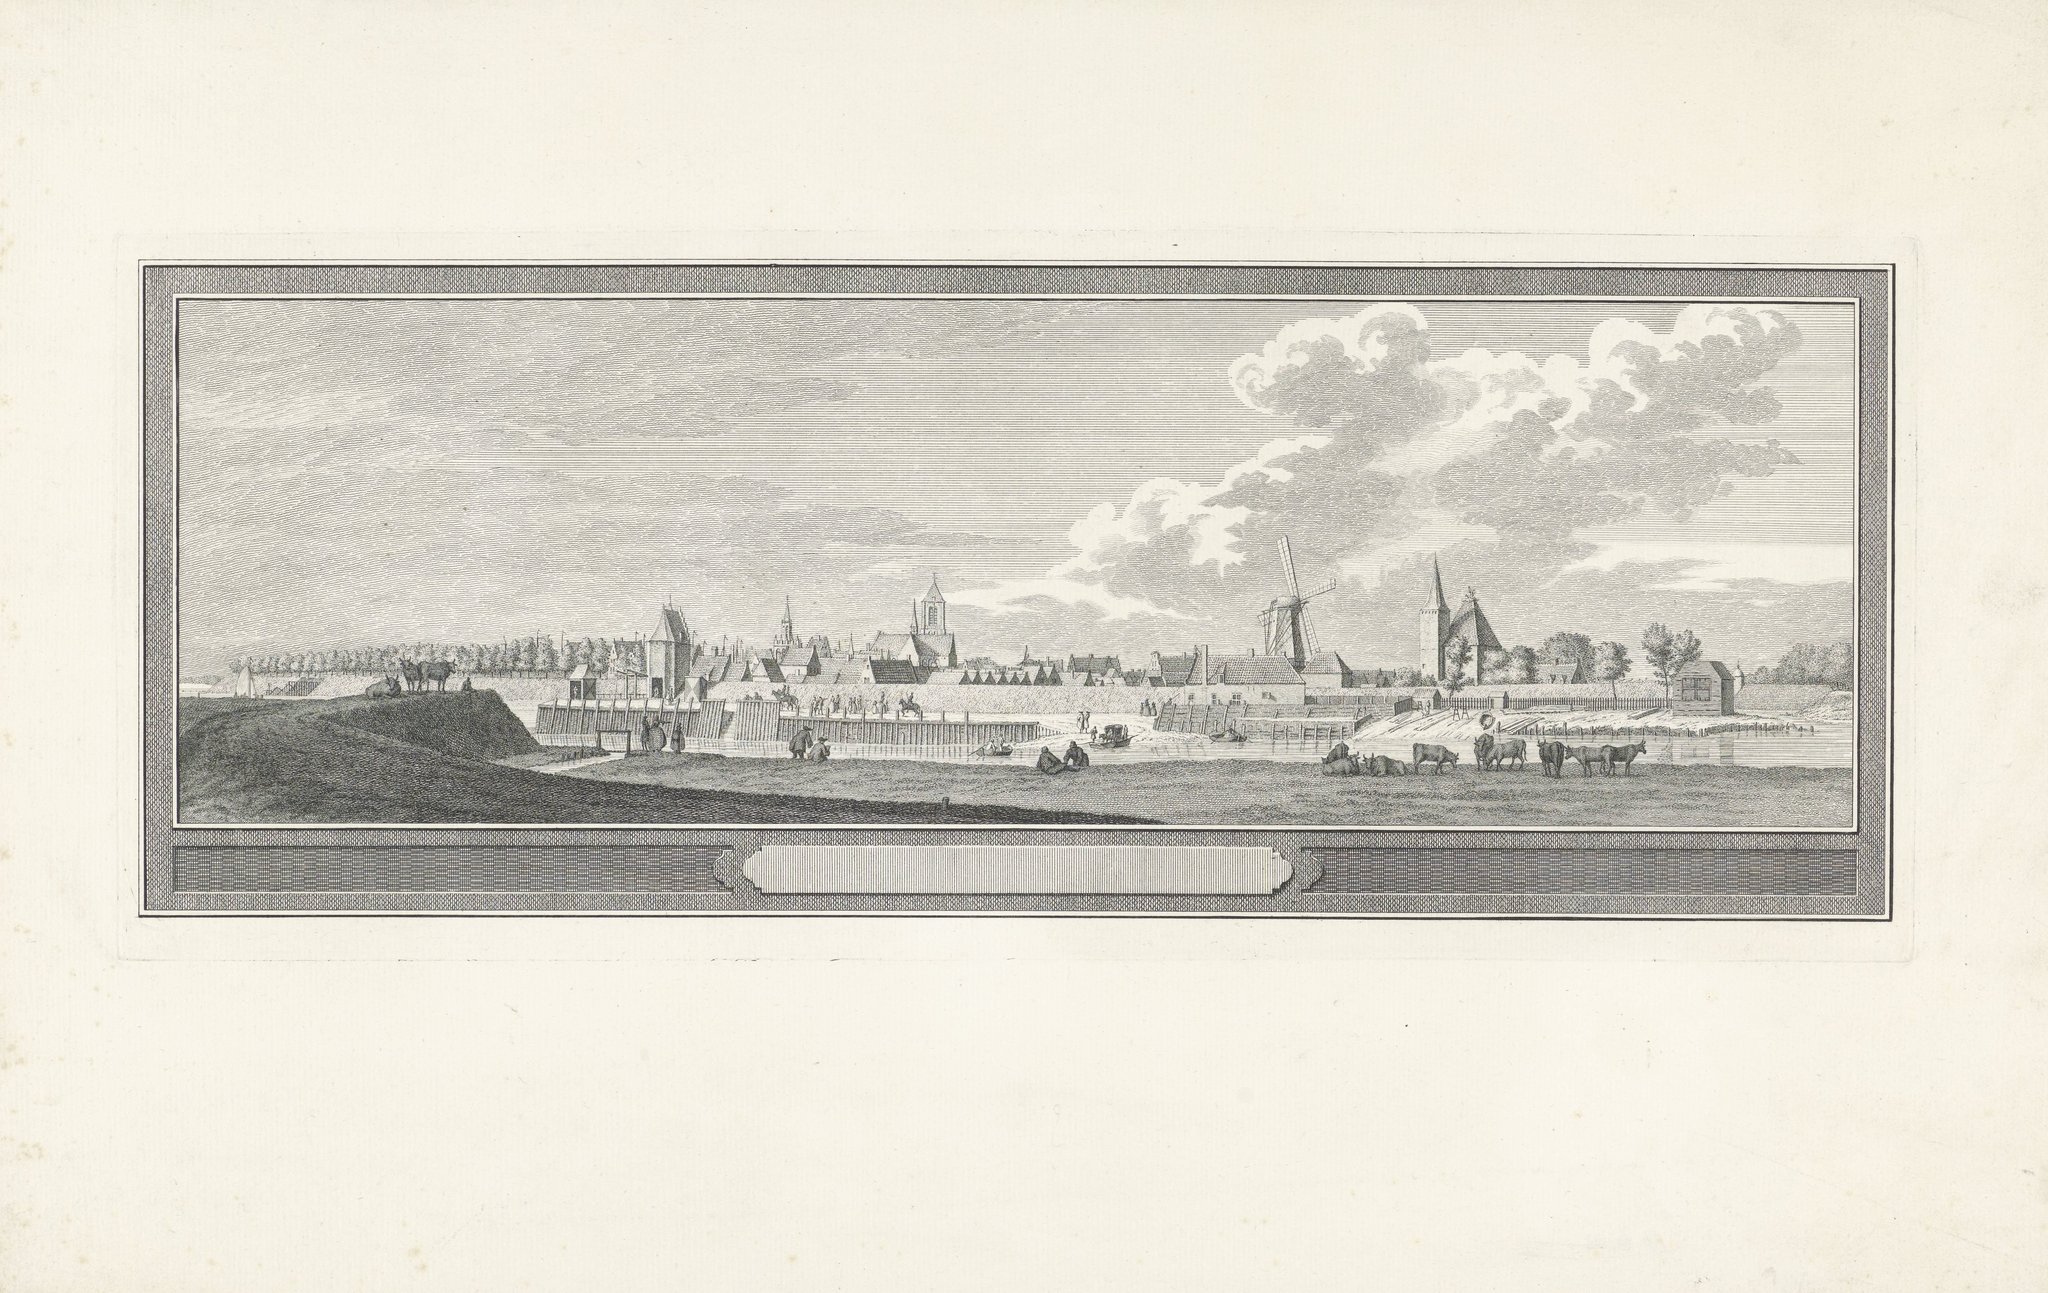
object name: print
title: Gezicht op Tholen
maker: jan caspar philips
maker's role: draughtsman, print maker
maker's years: 1700-1775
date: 1743-1752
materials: paper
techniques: etching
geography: amsterdam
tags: church (exterior), fortified city, city-gate, prospect of city, town panorama, silhouette of city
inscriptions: collector's mark: Lugt 2228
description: Gezicht op Tholen, gezien vanaf de overkant van de veste.